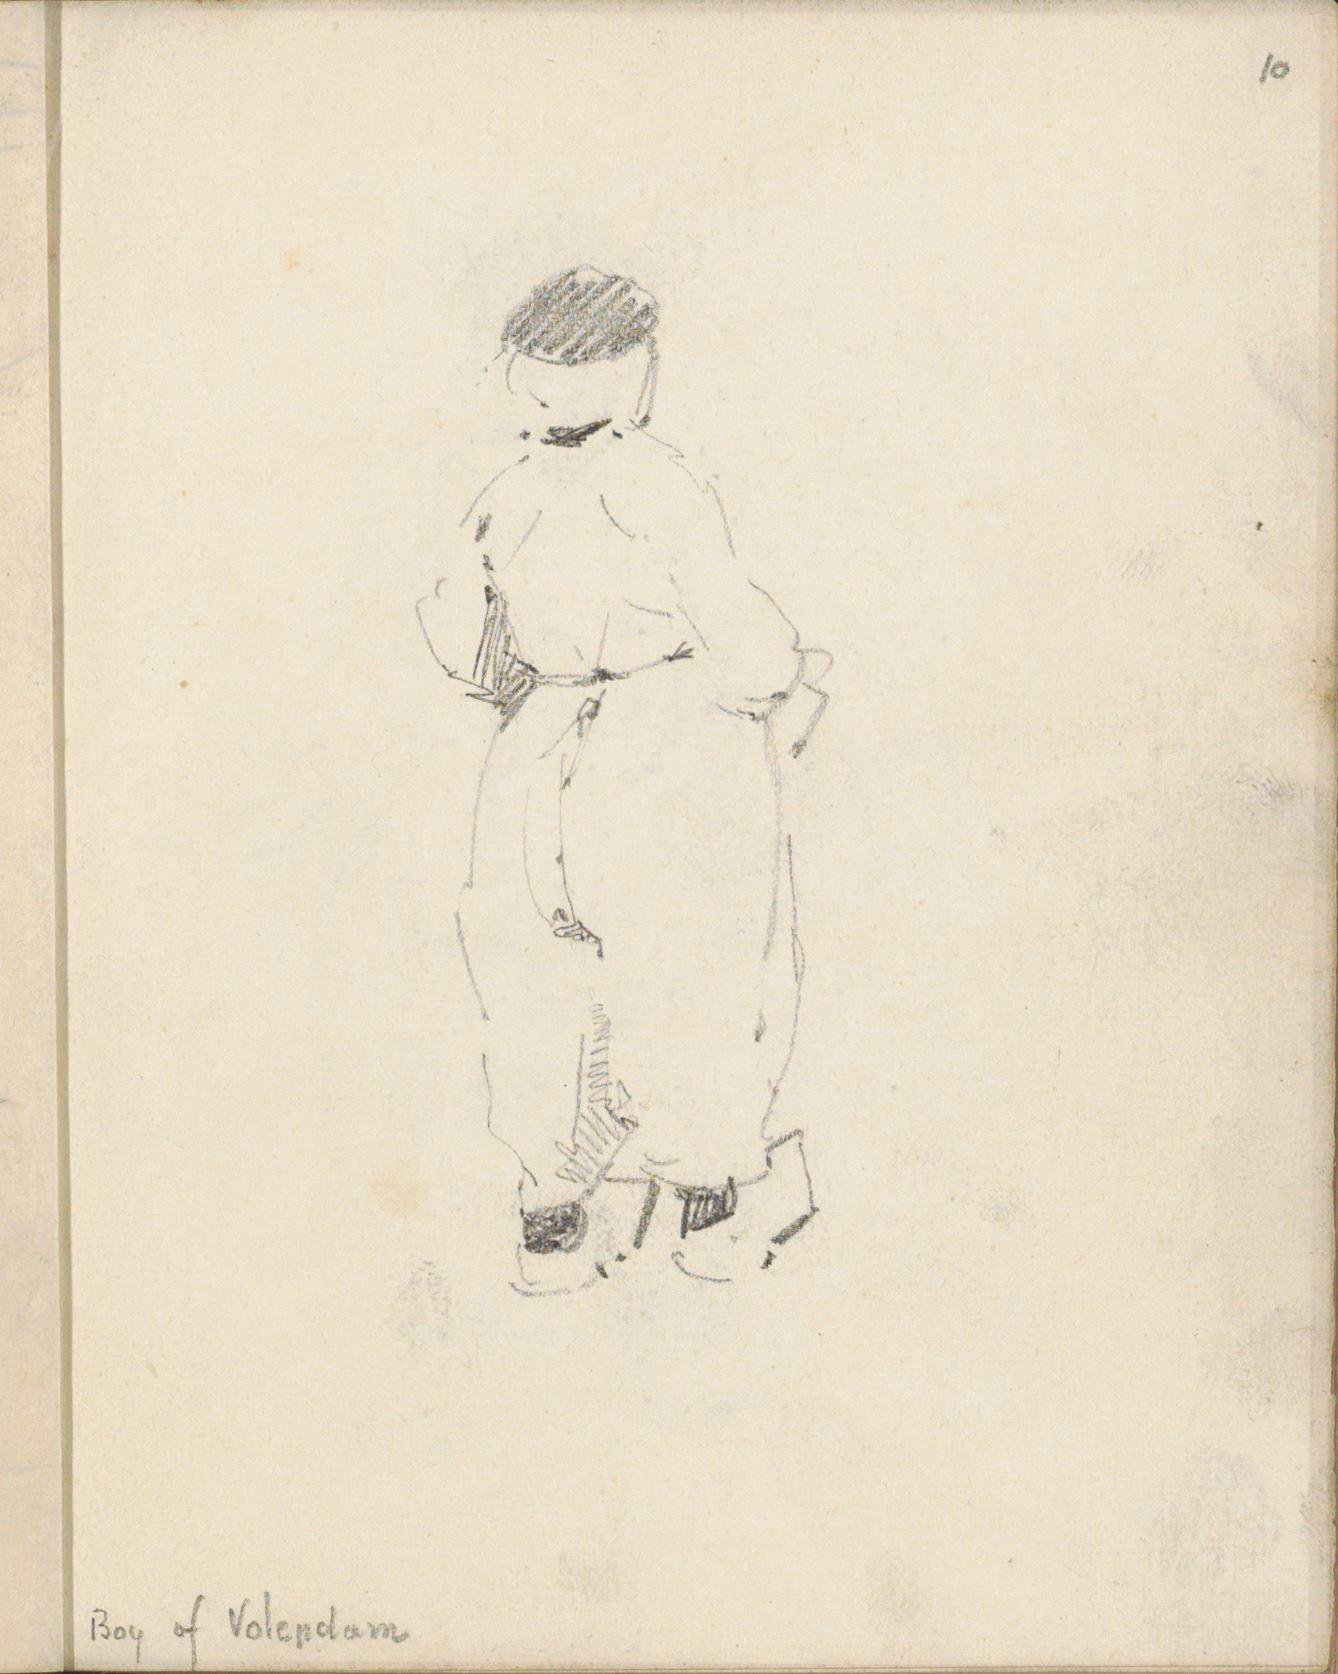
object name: sketchbook leaf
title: Jongen in Volendammer kostuum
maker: alfred william rich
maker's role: draughtsman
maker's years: 1856-1921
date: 1892-1893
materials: paper, pencil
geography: volendam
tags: boy (child between toddler and youth), wooden shoes, clogs, folk costume, regional costume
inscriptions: annotation: ‘Boy of Volendam’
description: Blad 10 recto uit een schetsboek met 86 bladen.